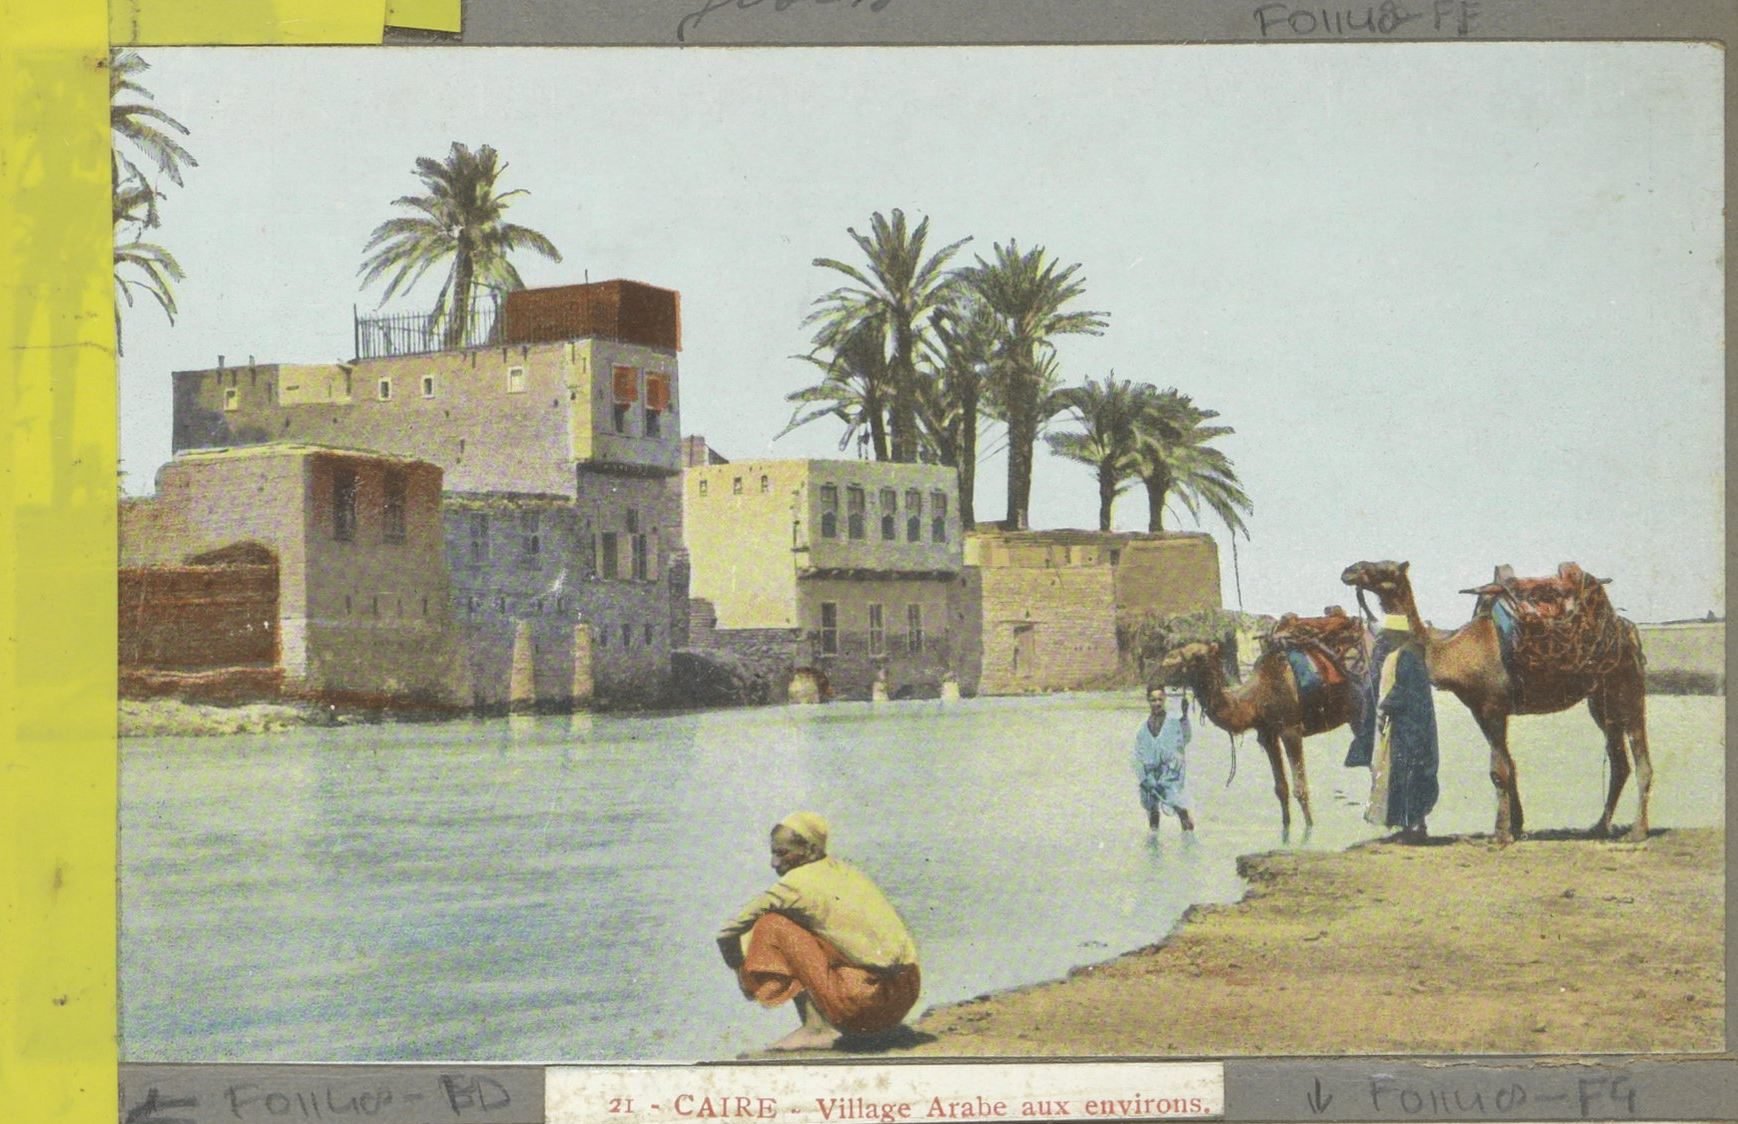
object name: photograph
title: CAIRE - Village Arabe aux environs.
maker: Anonymous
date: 1895-1905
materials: paper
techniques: autotype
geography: egypt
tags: prospect of village, silhouette of village, river bank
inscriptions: number: ‘21’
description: Onderdeel van Reisalbum met foto's van bezienswaardigheden in Griekenland en Egypte.